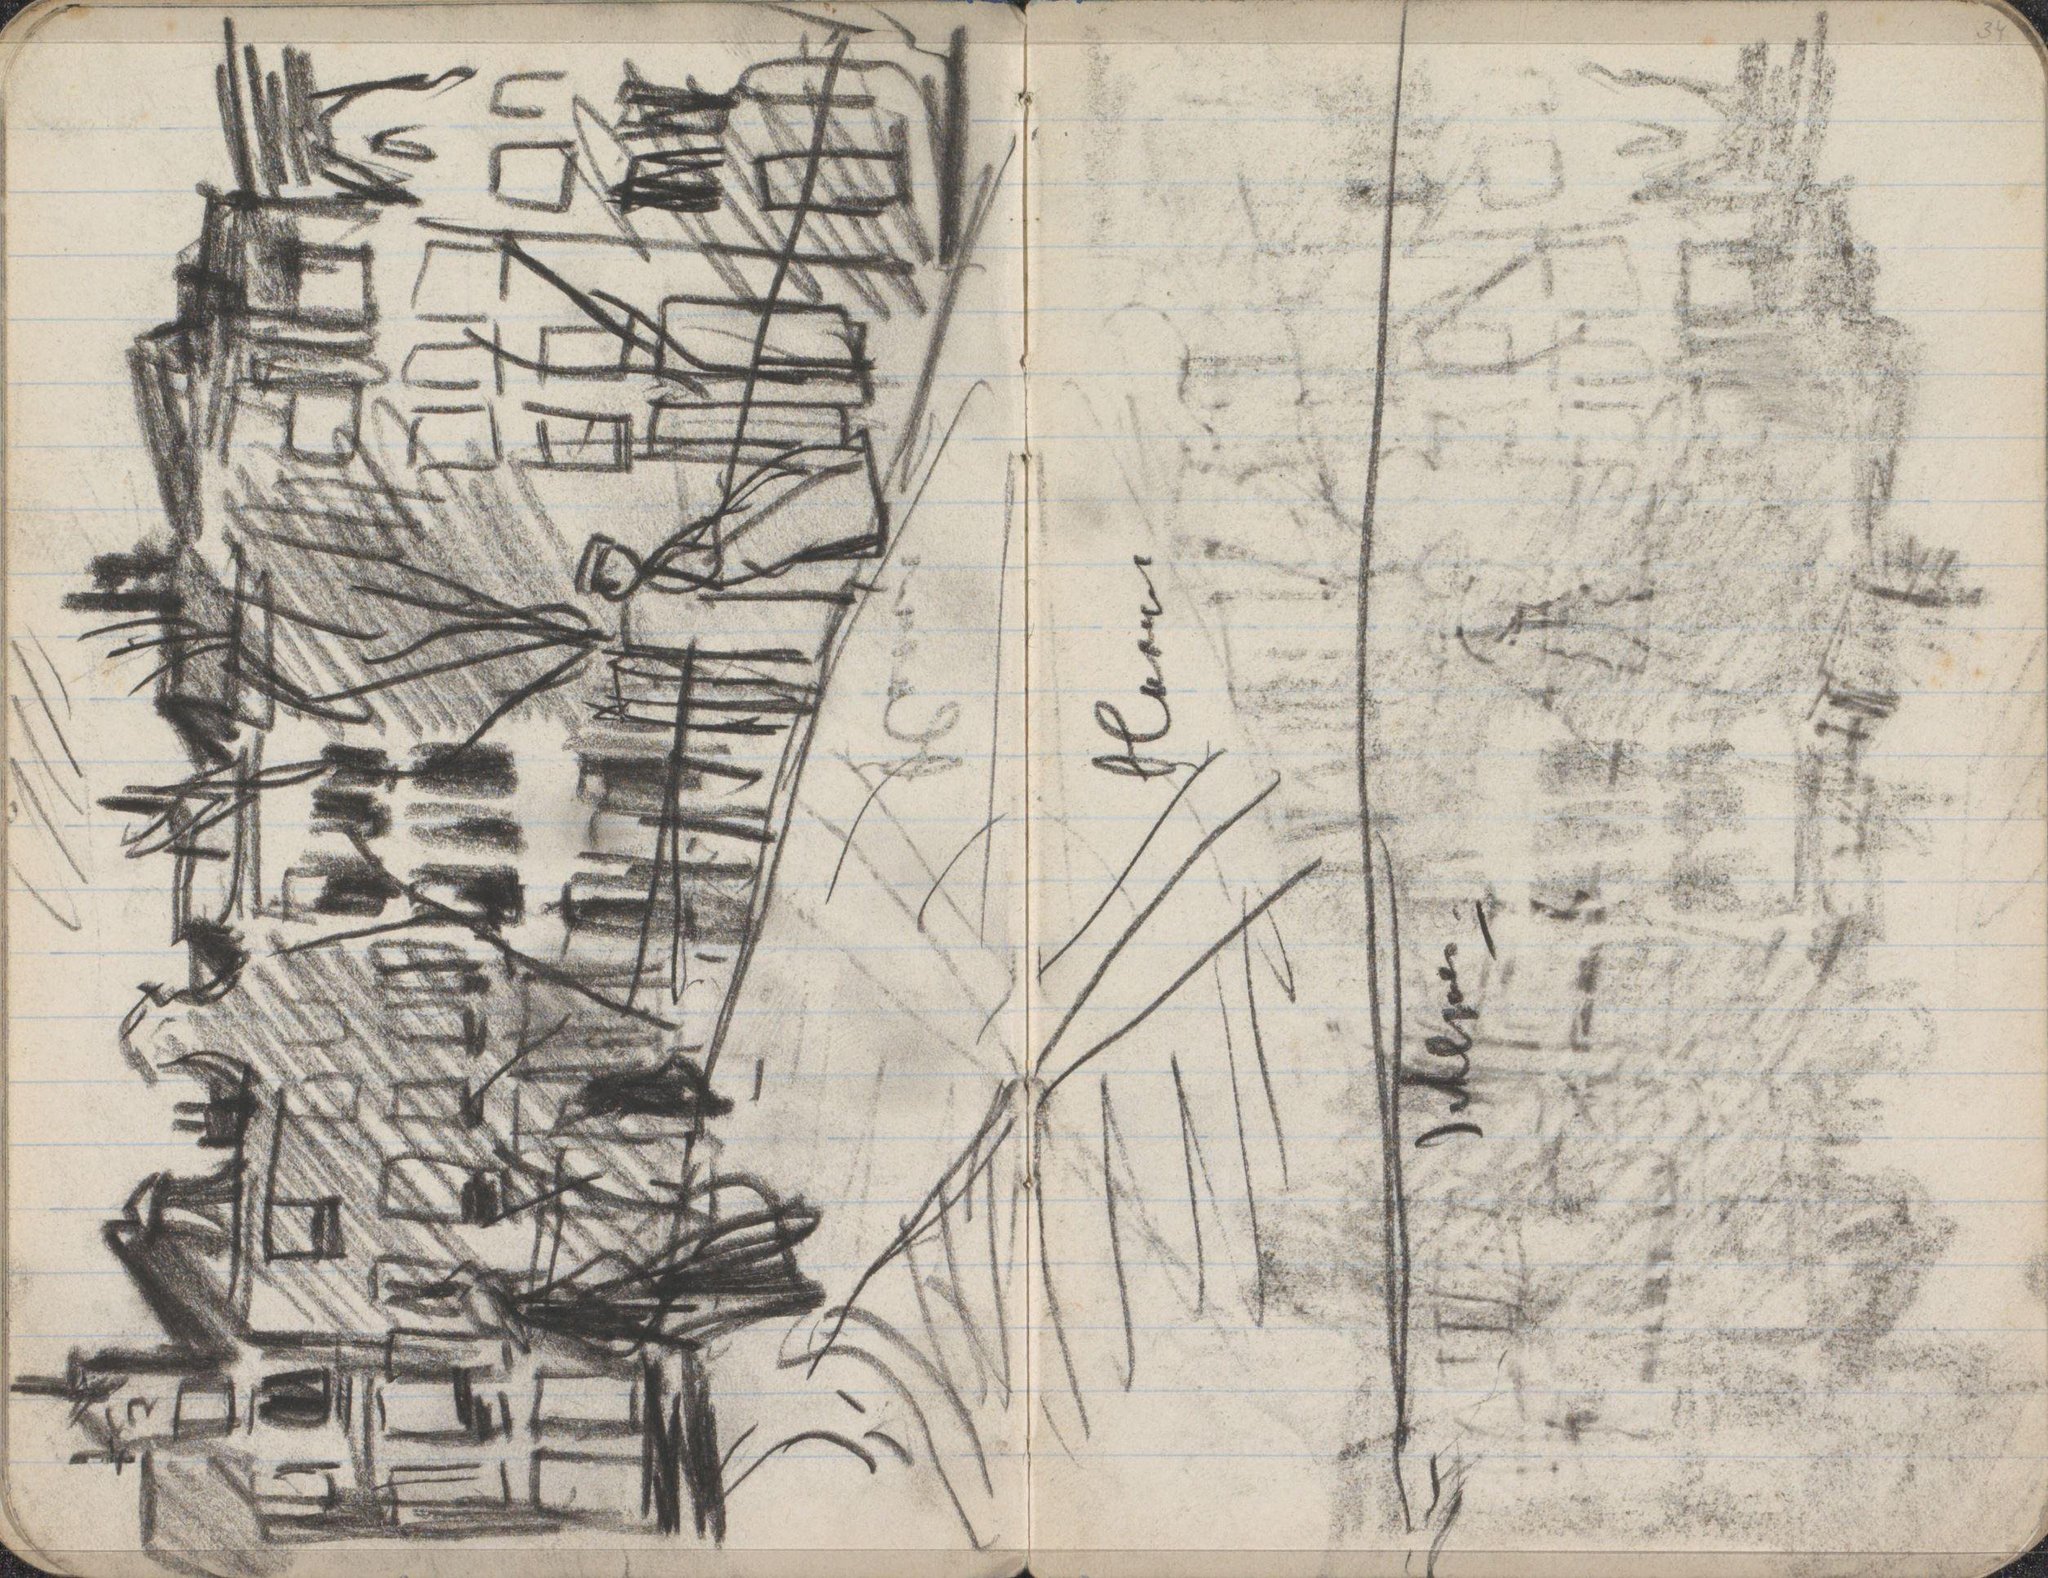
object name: sketchbook leaf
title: Brug over een gracht in Amsterdam, mogelijk de Krom Boomssloot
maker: george hendrik breitner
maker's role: draughtsman, painter, print maker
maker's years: 1857-1923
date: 1898-1902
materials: chalk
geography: amsterdam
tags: bridge in city across river, canal, etc. (+ city(-scape) with figures, staffage), civic architecture; edifices; dwellings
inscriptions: annotation: ‘schepen’, : ‘blaauw’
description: Pagina 33 en pagina 34 uit een schetsboek met 42 bladen.